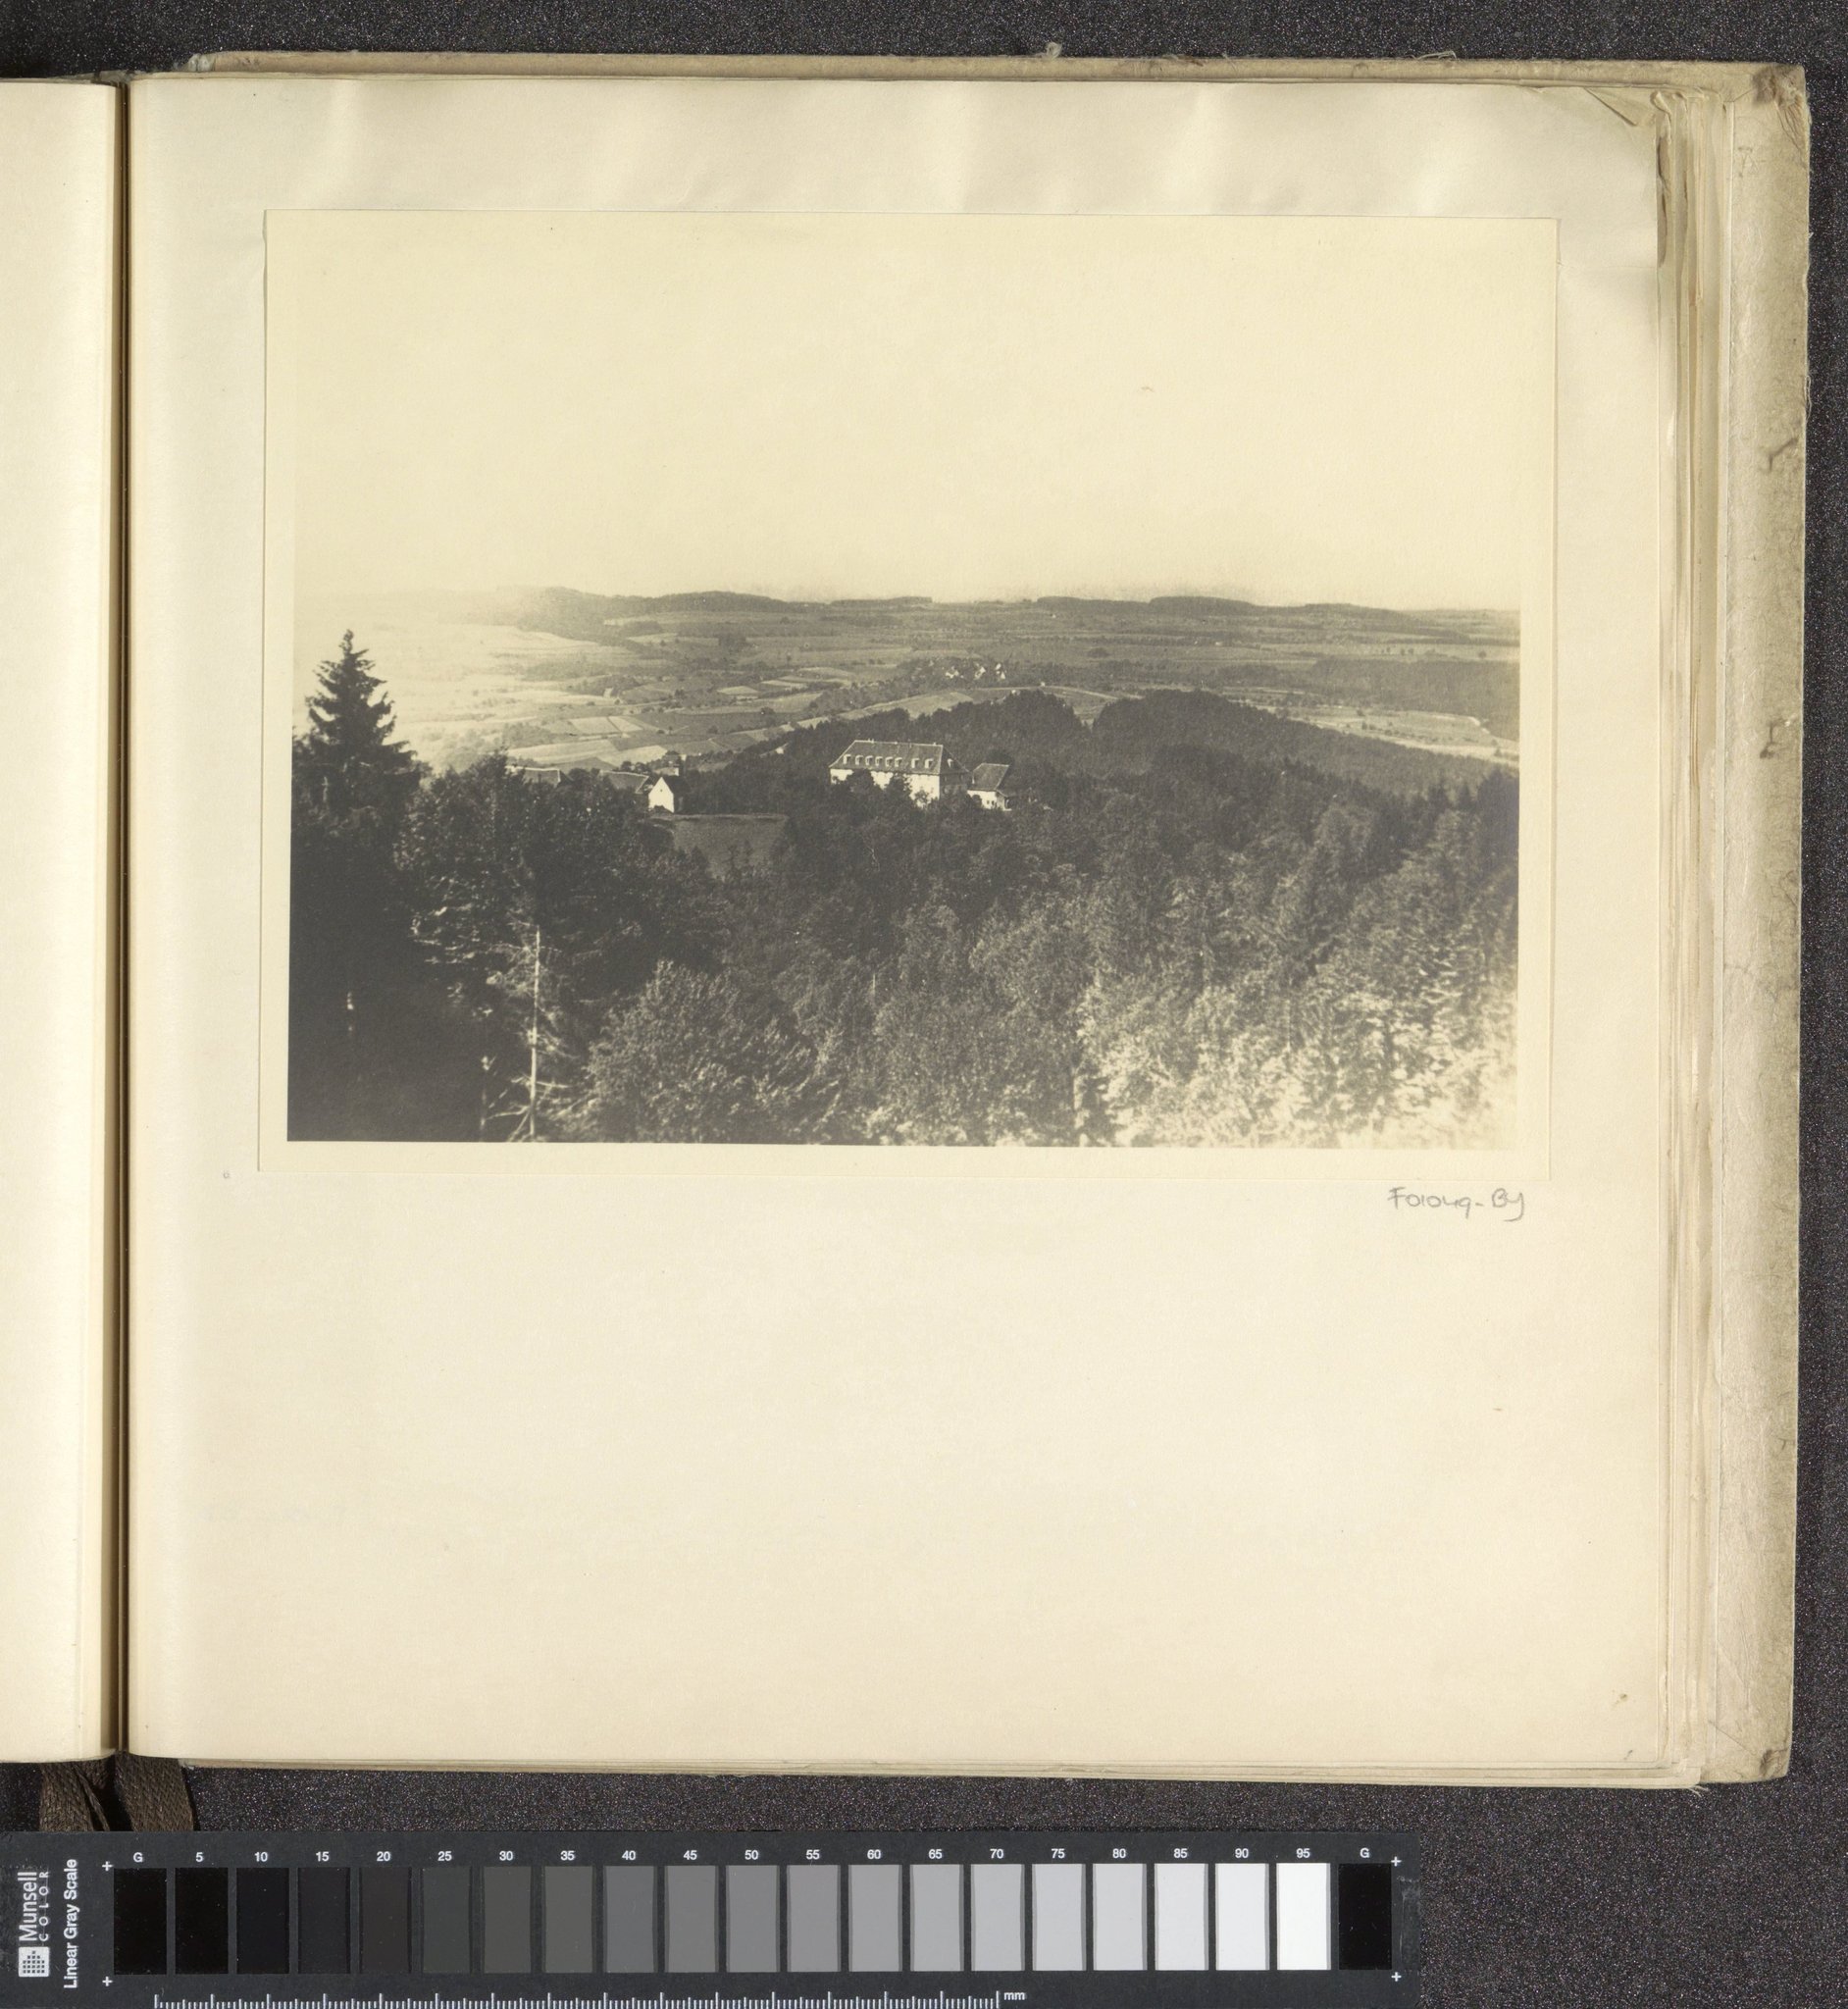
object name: photograph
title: Gezicht op een schoolgebouw voor jonge leerlingen in Hermannsberg, behorend bij Schule Schloss Salem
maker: Anonymous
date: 1929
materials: photographic support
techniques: gelatin silver print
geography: hermannsberg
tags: prospect of village, silhouette of village, education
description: Onderdeel van Fotoalbum van Schule Schloss Salem.